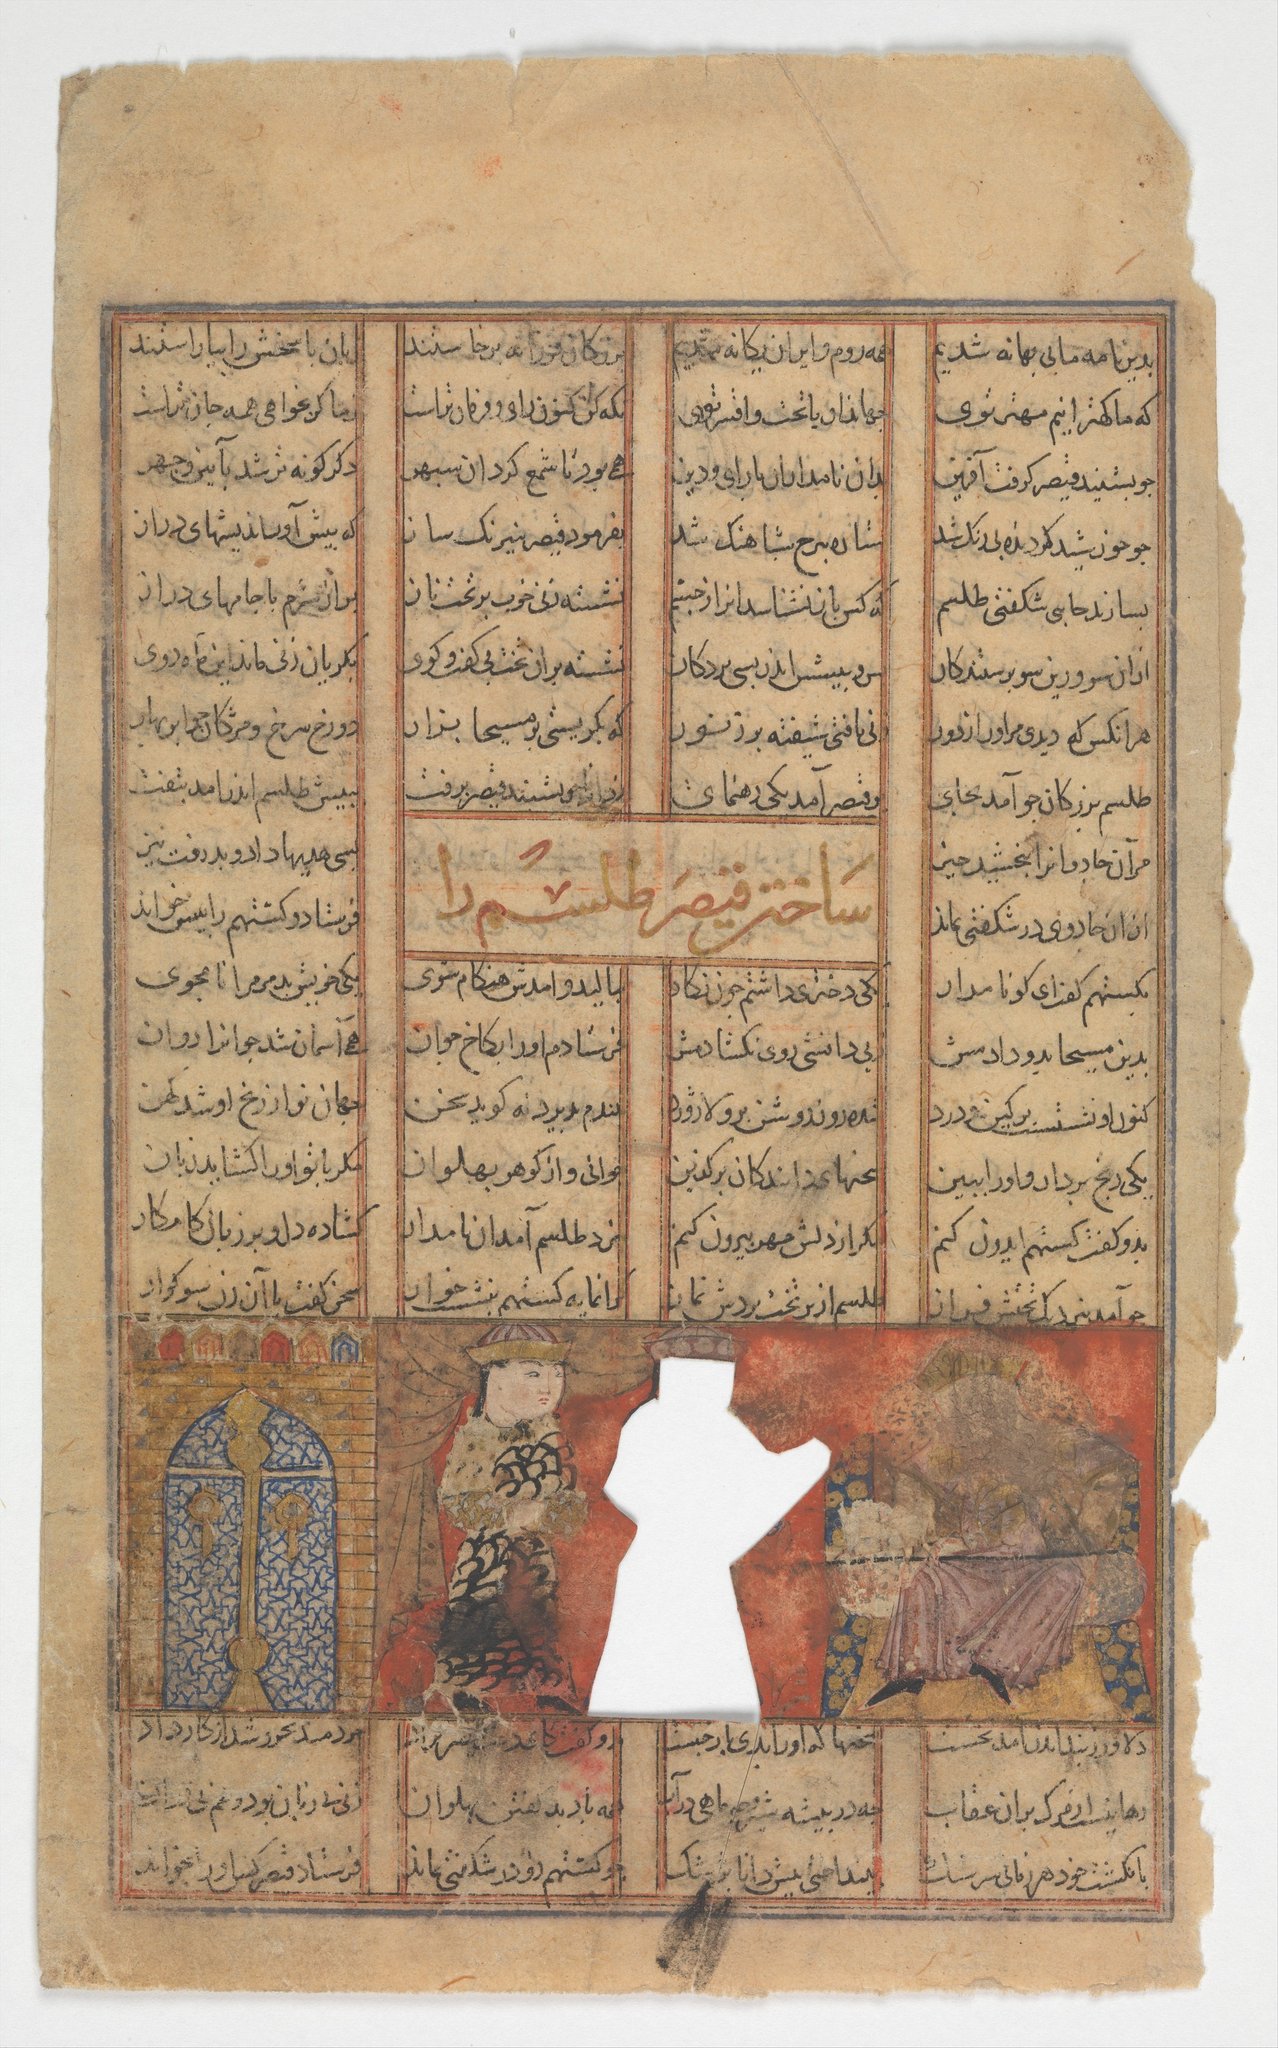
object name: folio from an illustrated manuscript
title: "Caesar Makes a Talisman", Folio from a Shahnama (Book of Kings)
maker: abu'l qasim firdausi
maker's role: author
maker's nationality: iranian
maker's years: 935-1020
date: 1330-1340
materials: gold, ink, paper, watercolor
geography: iran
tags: poetry,men